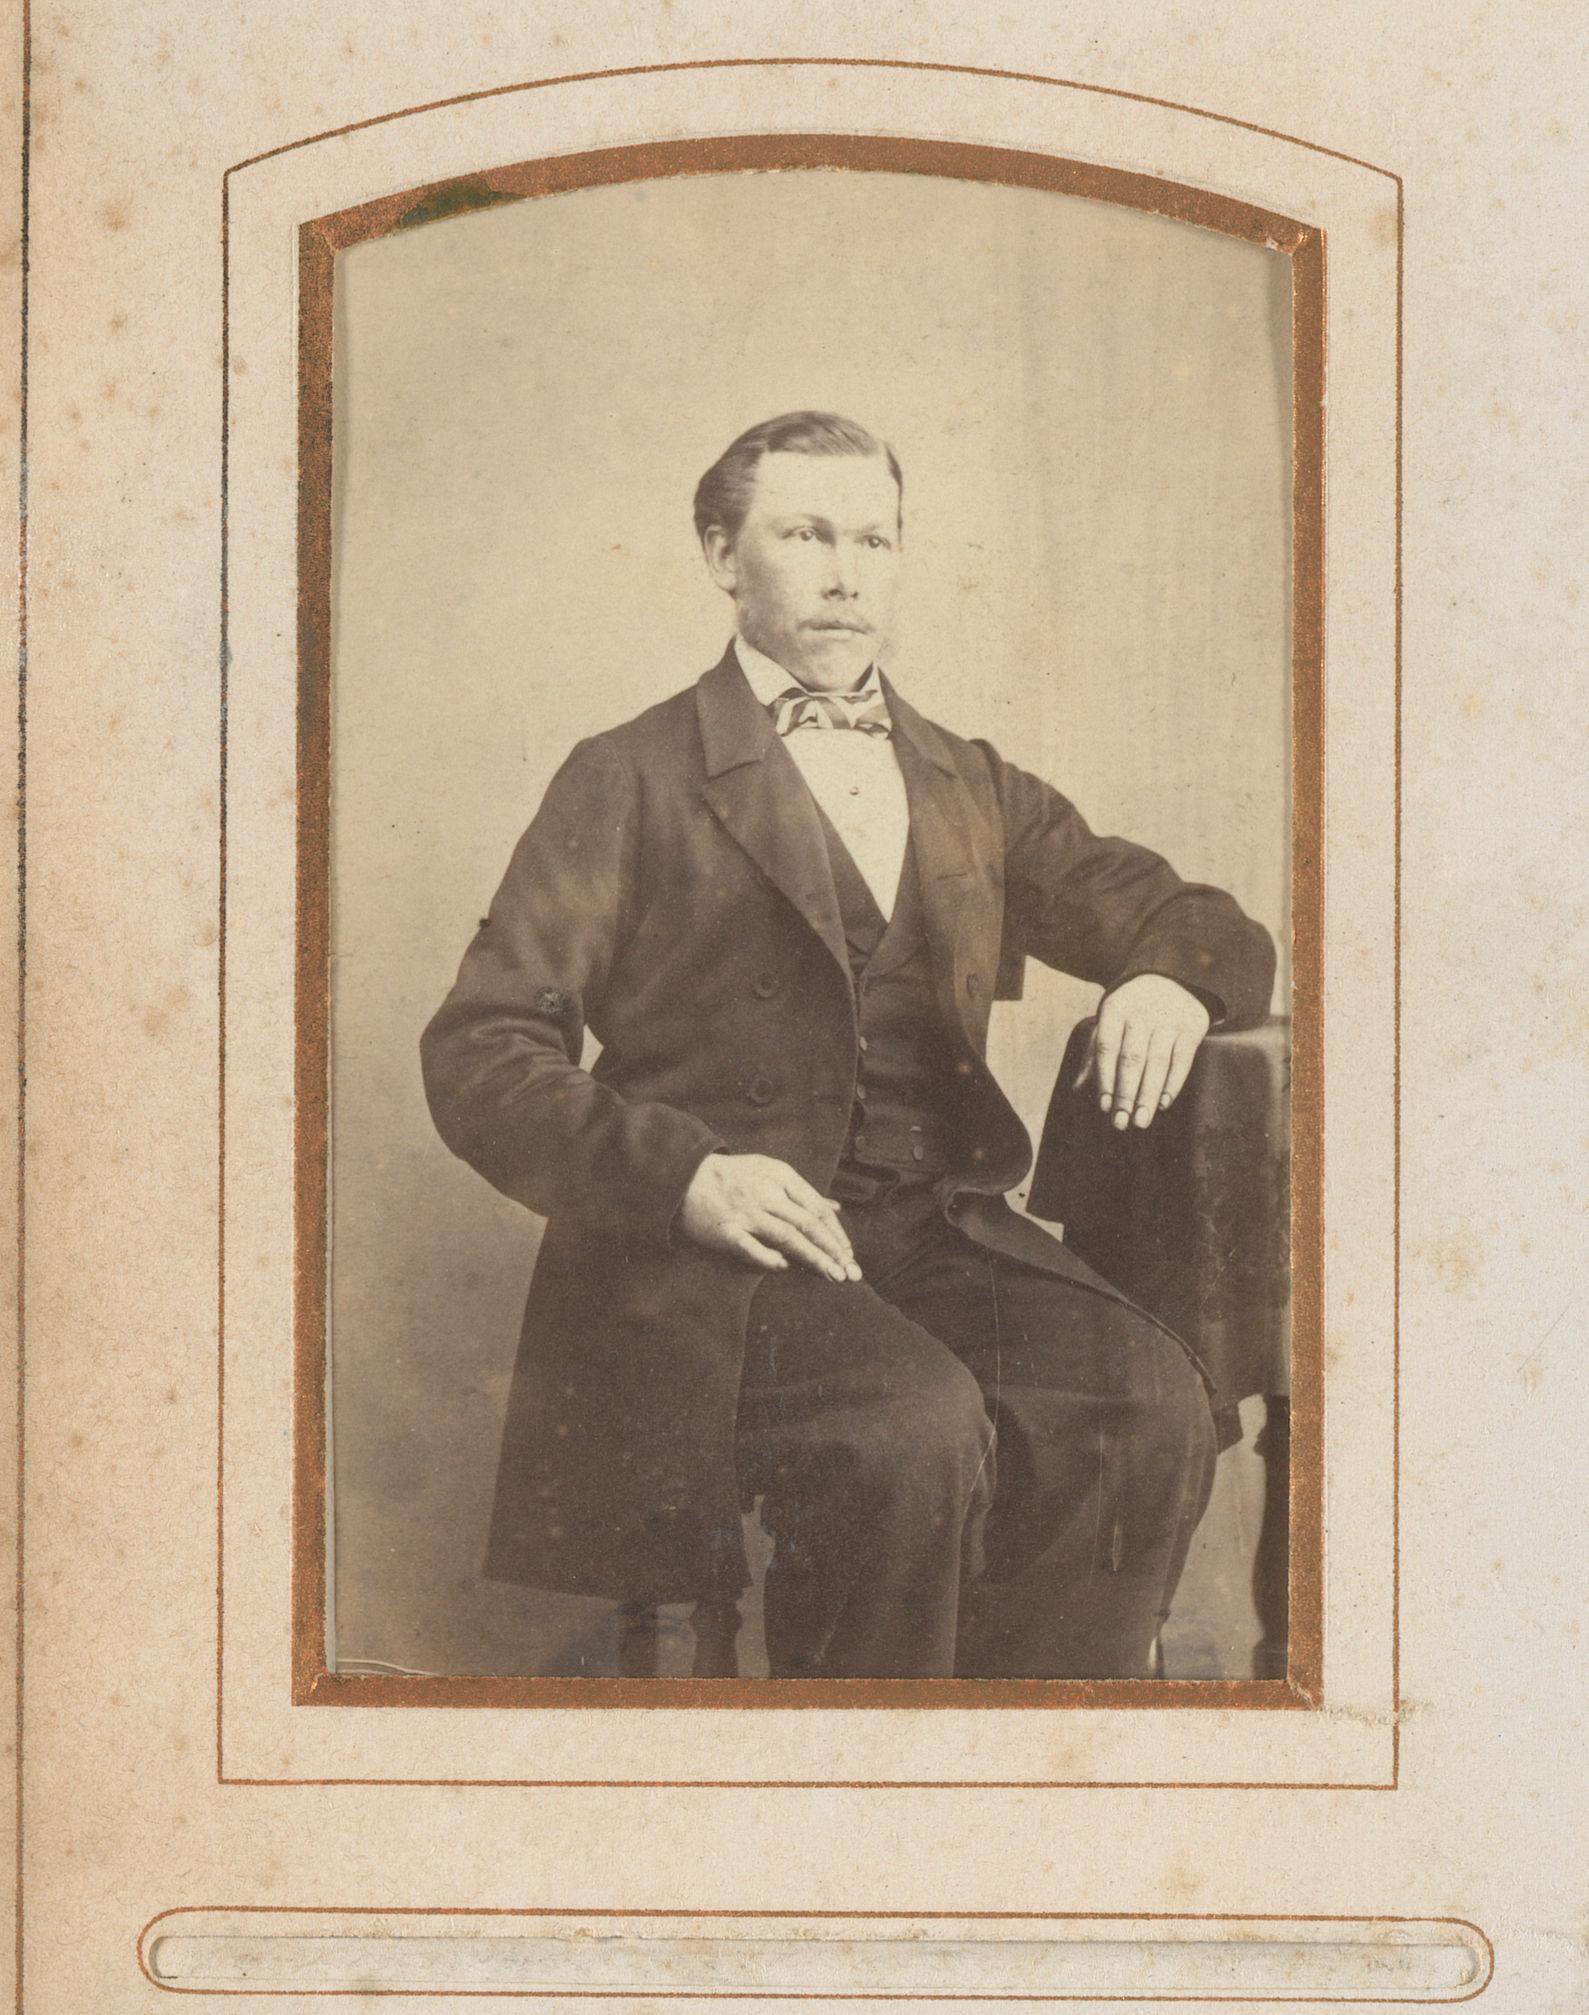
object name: photograph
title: Portret van een zittende man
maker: Anonymous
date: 1865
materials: cardboard, photographic support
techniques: albumen print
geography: sweden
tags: sitting figure, historical persons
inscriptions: annotation: ‘Zweeds’, date: ‘1865’